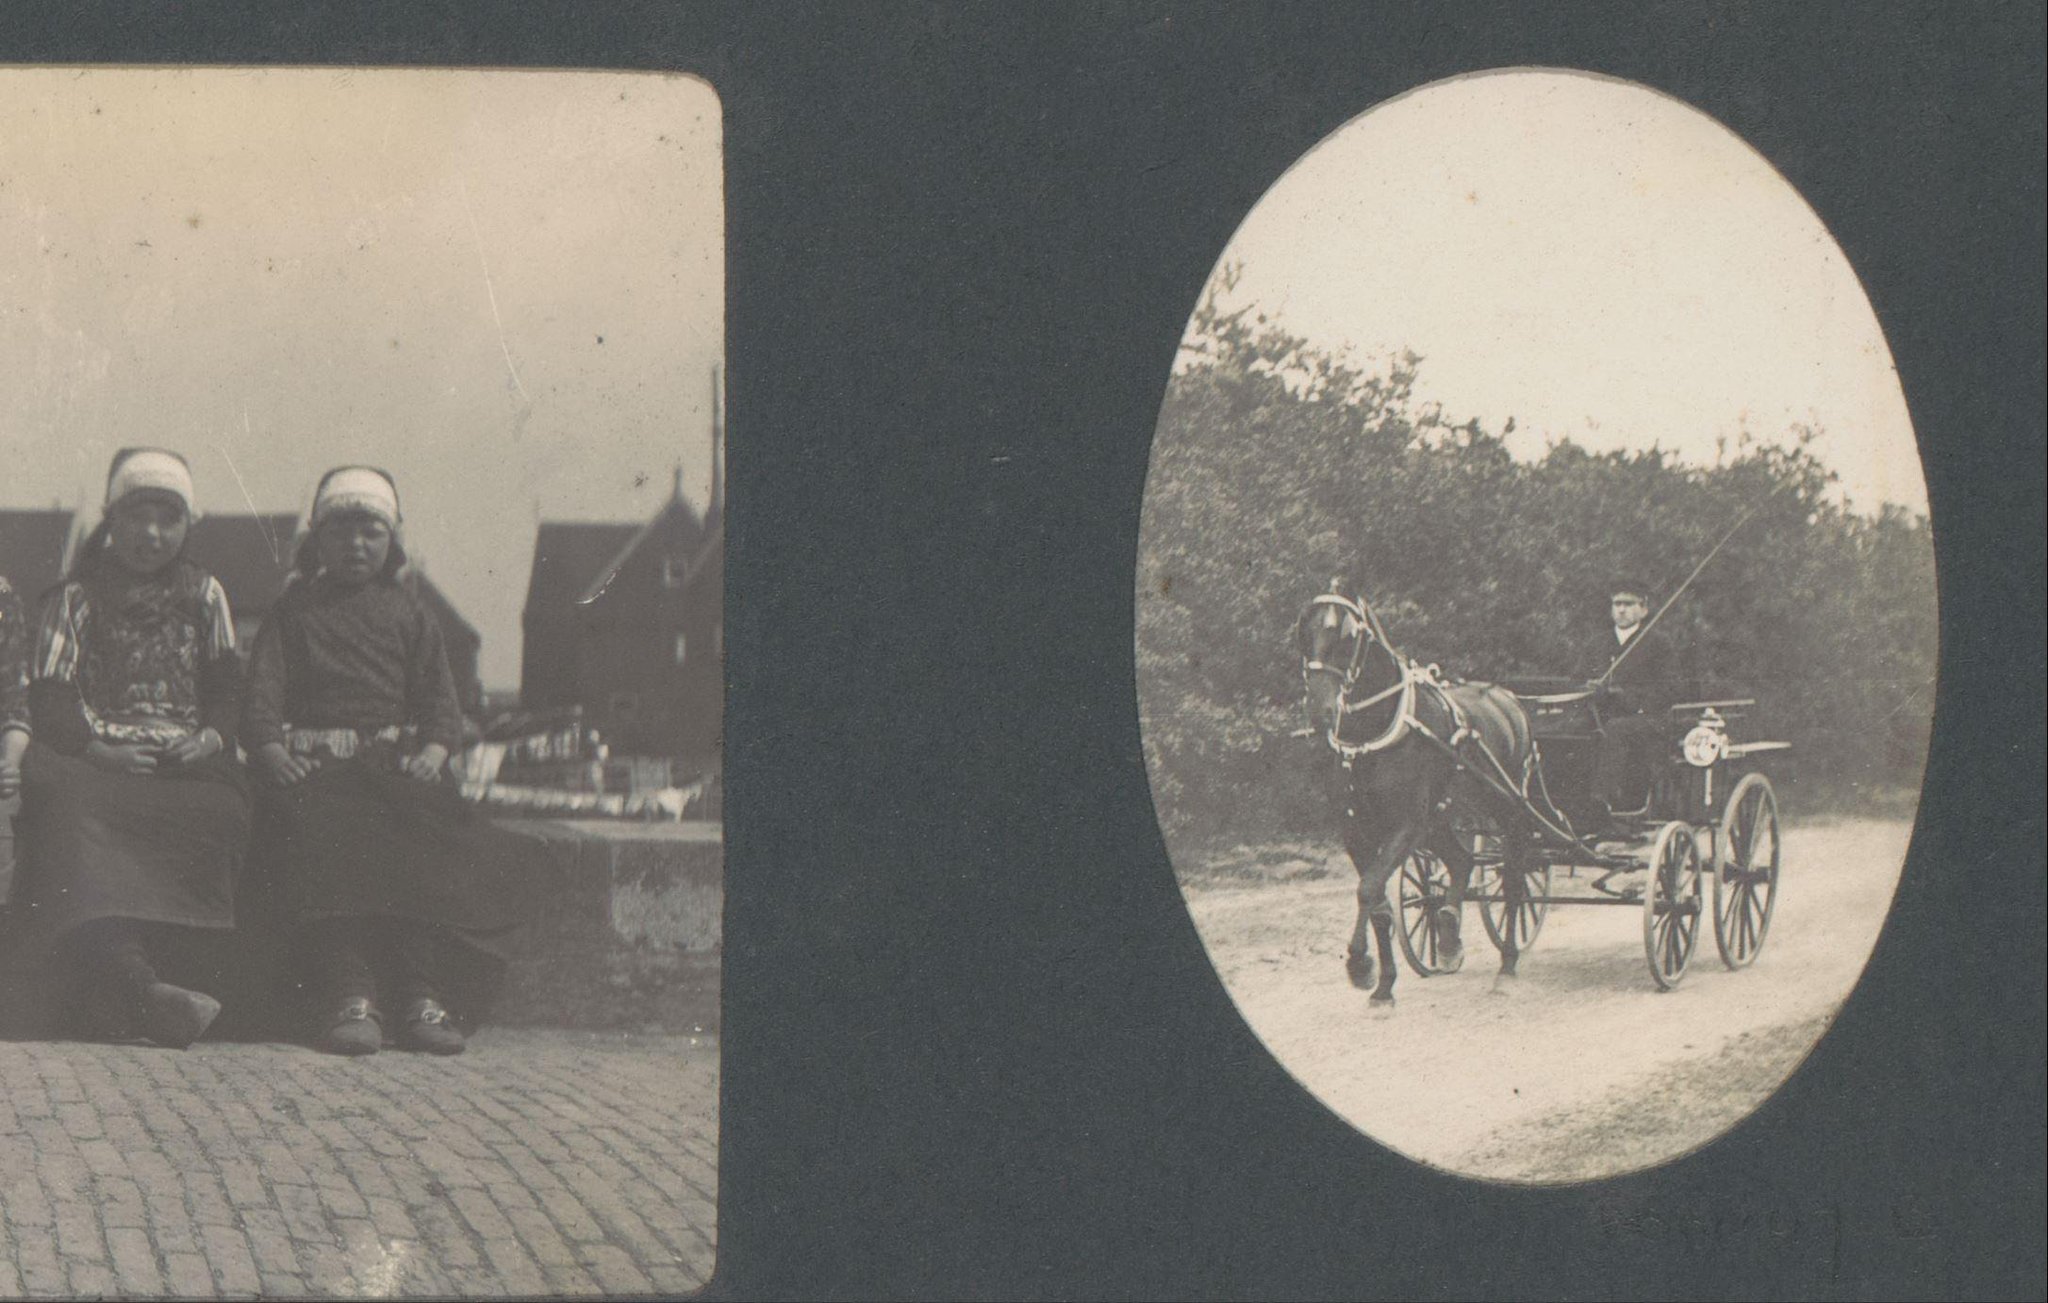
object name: album leaf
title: Man in een rijtuig op een landweg, vermoedelijk in Nederland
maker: Anonymous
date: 1902-1906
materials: cardboard, paper, photographic support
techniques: gelatin silver print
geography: netherlands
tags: four-wheeled, animal-drawn vehicle, e.g.: cab, carriage, coach, netherlands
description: Onderdeel van Reisalbum van een Nederlandse familie met bezienswaardigheden in Europa, Egypte en New York.